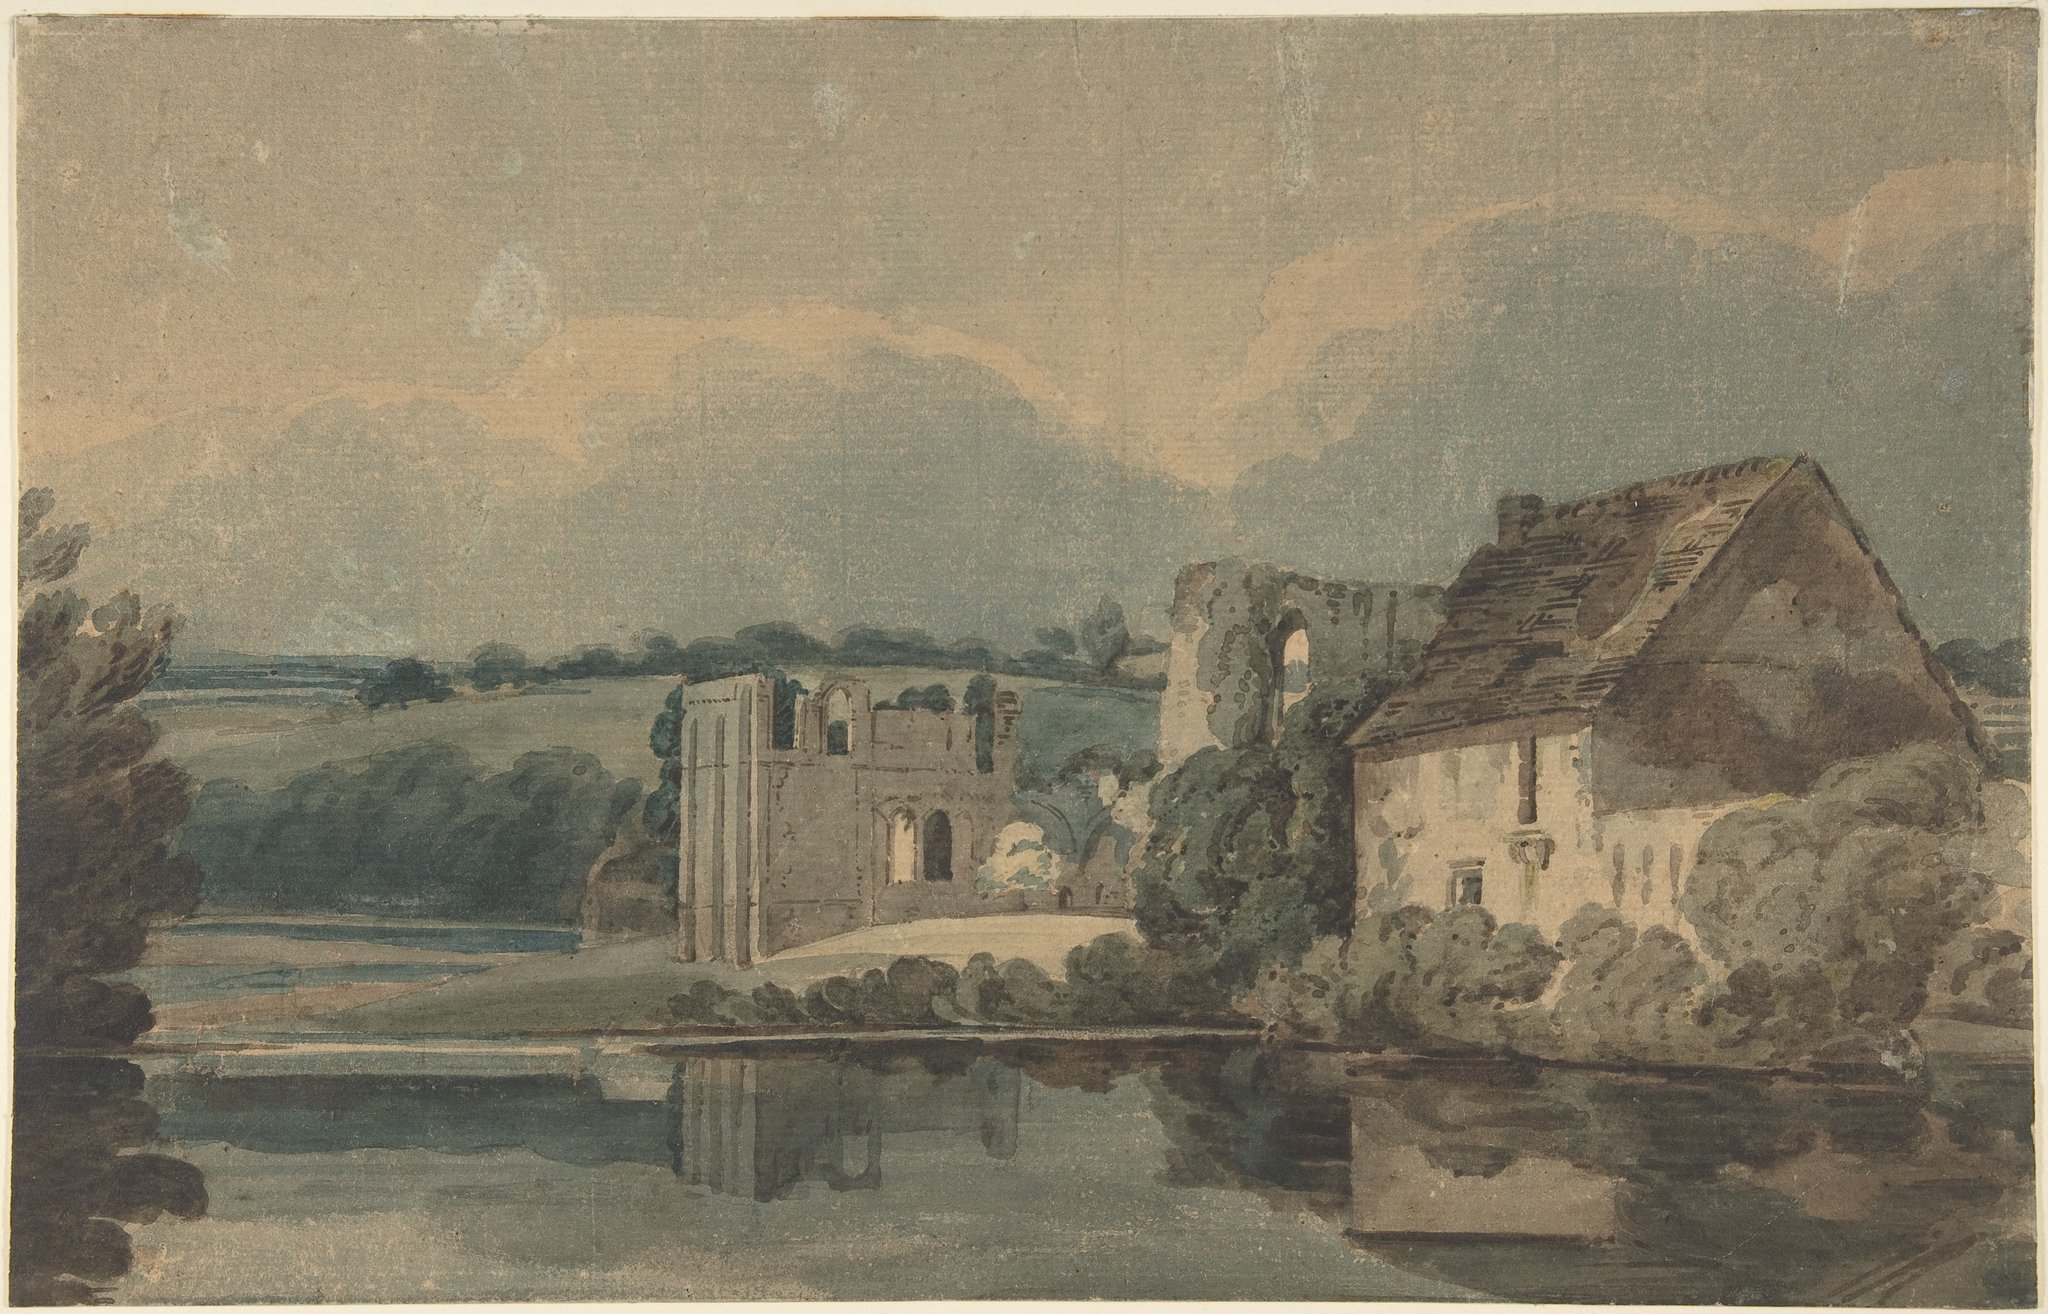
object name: drawing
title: Easby Abbey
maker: thomas girtin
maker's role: artist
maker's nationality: british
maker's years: 1775-1802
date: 1801-1900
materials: board, watercolor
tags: abbeys,landscapes